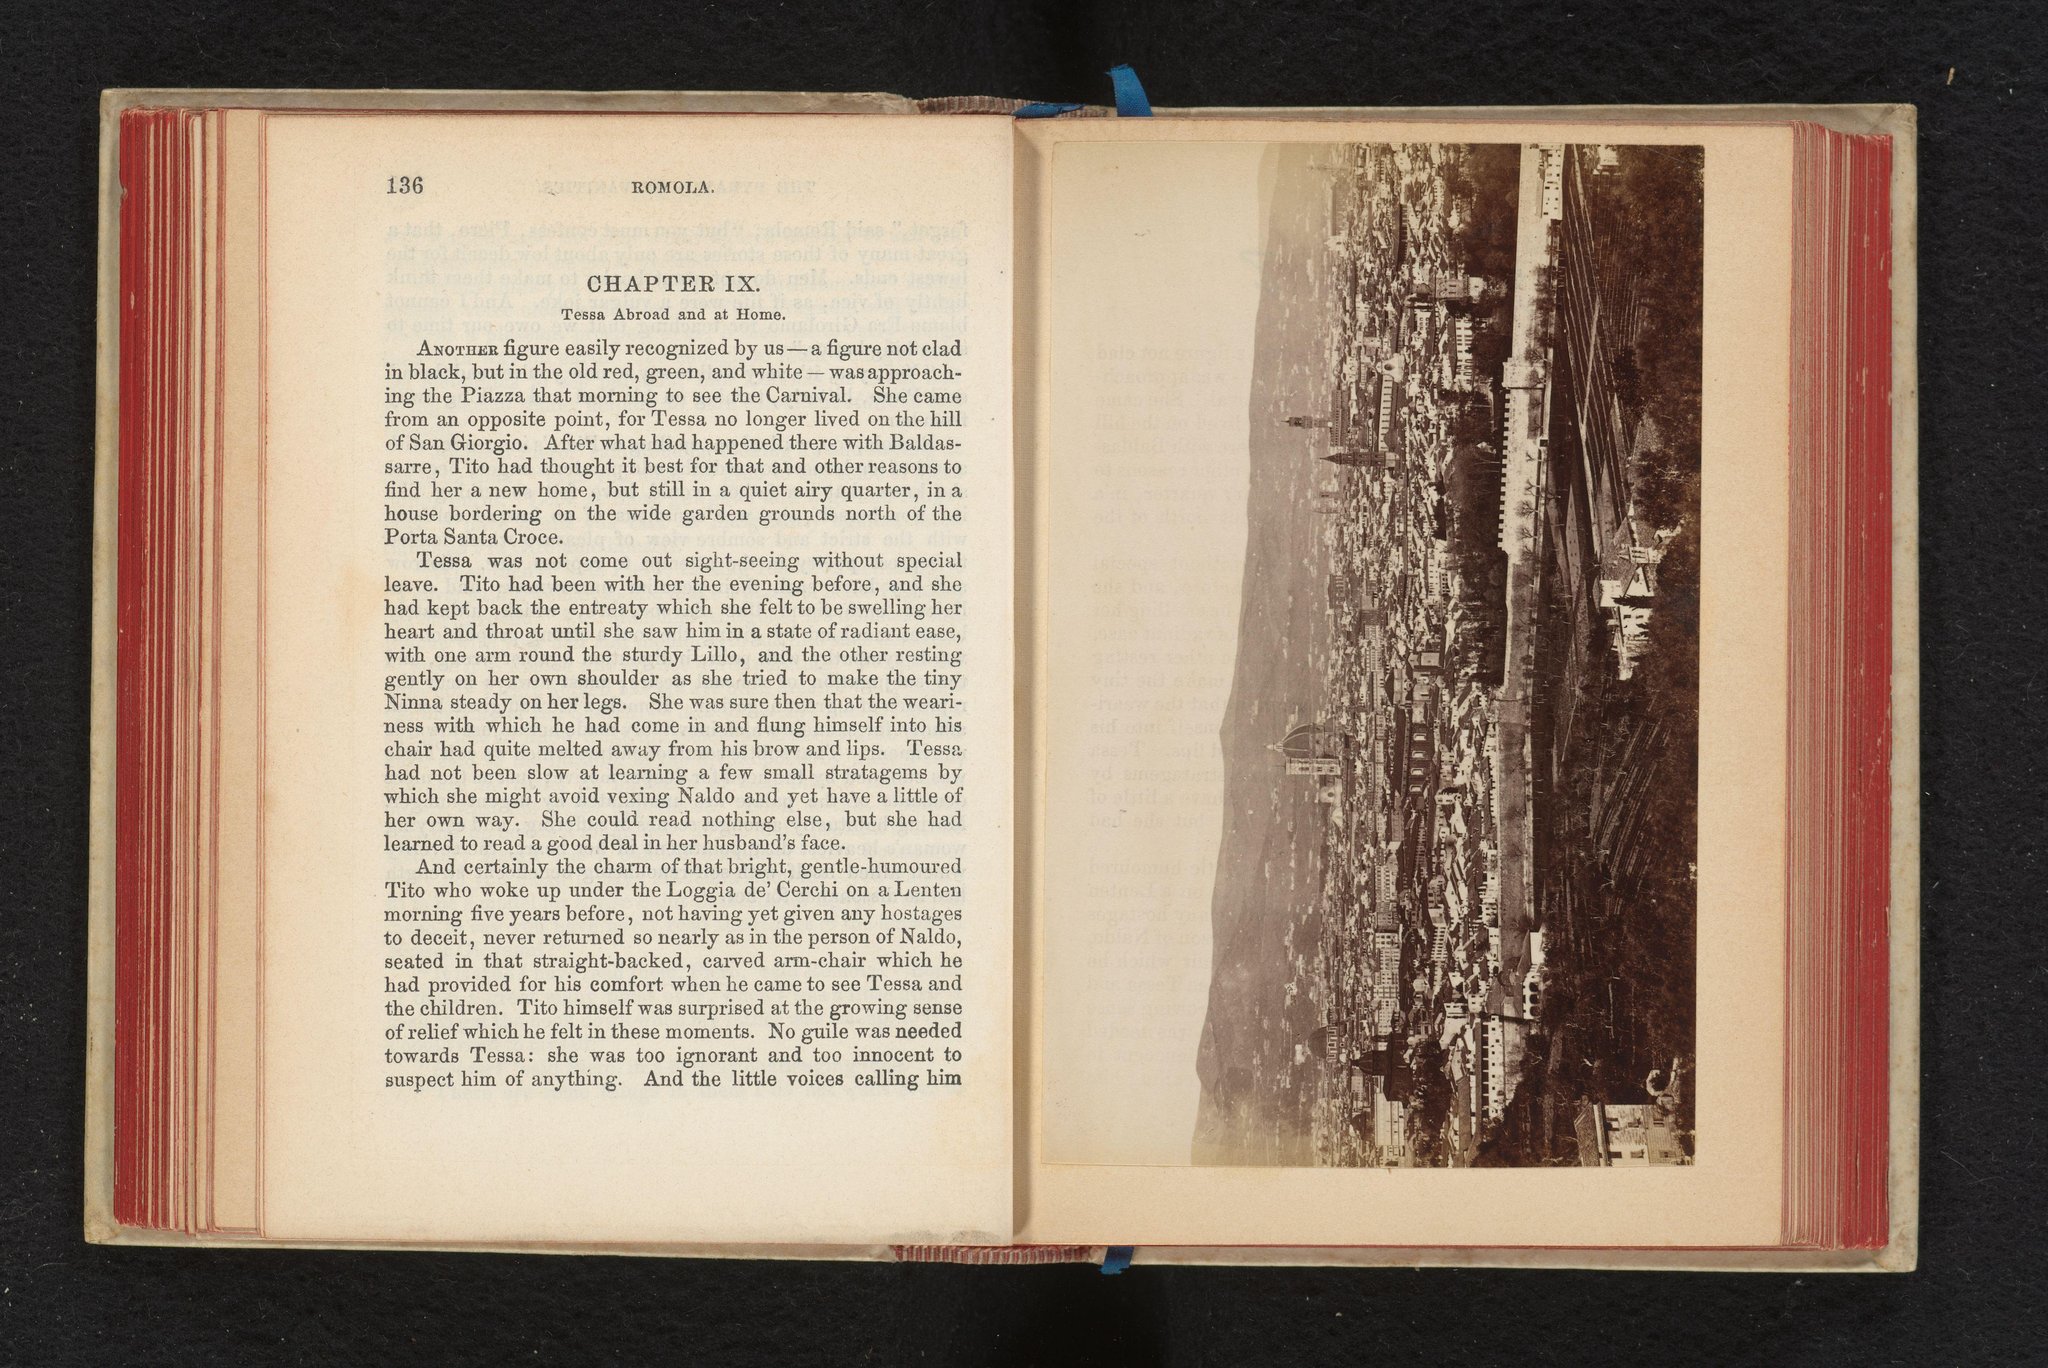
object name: photograph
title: Gezicht op Florence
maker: giacomo brogi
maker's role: fotograaf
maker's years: 1822-1881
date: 1858-1863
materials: paper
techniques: albumen print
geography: florence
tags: city-view in general; 'veduta'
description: Foto op ongenummerde pagina tegenover pagina 136.